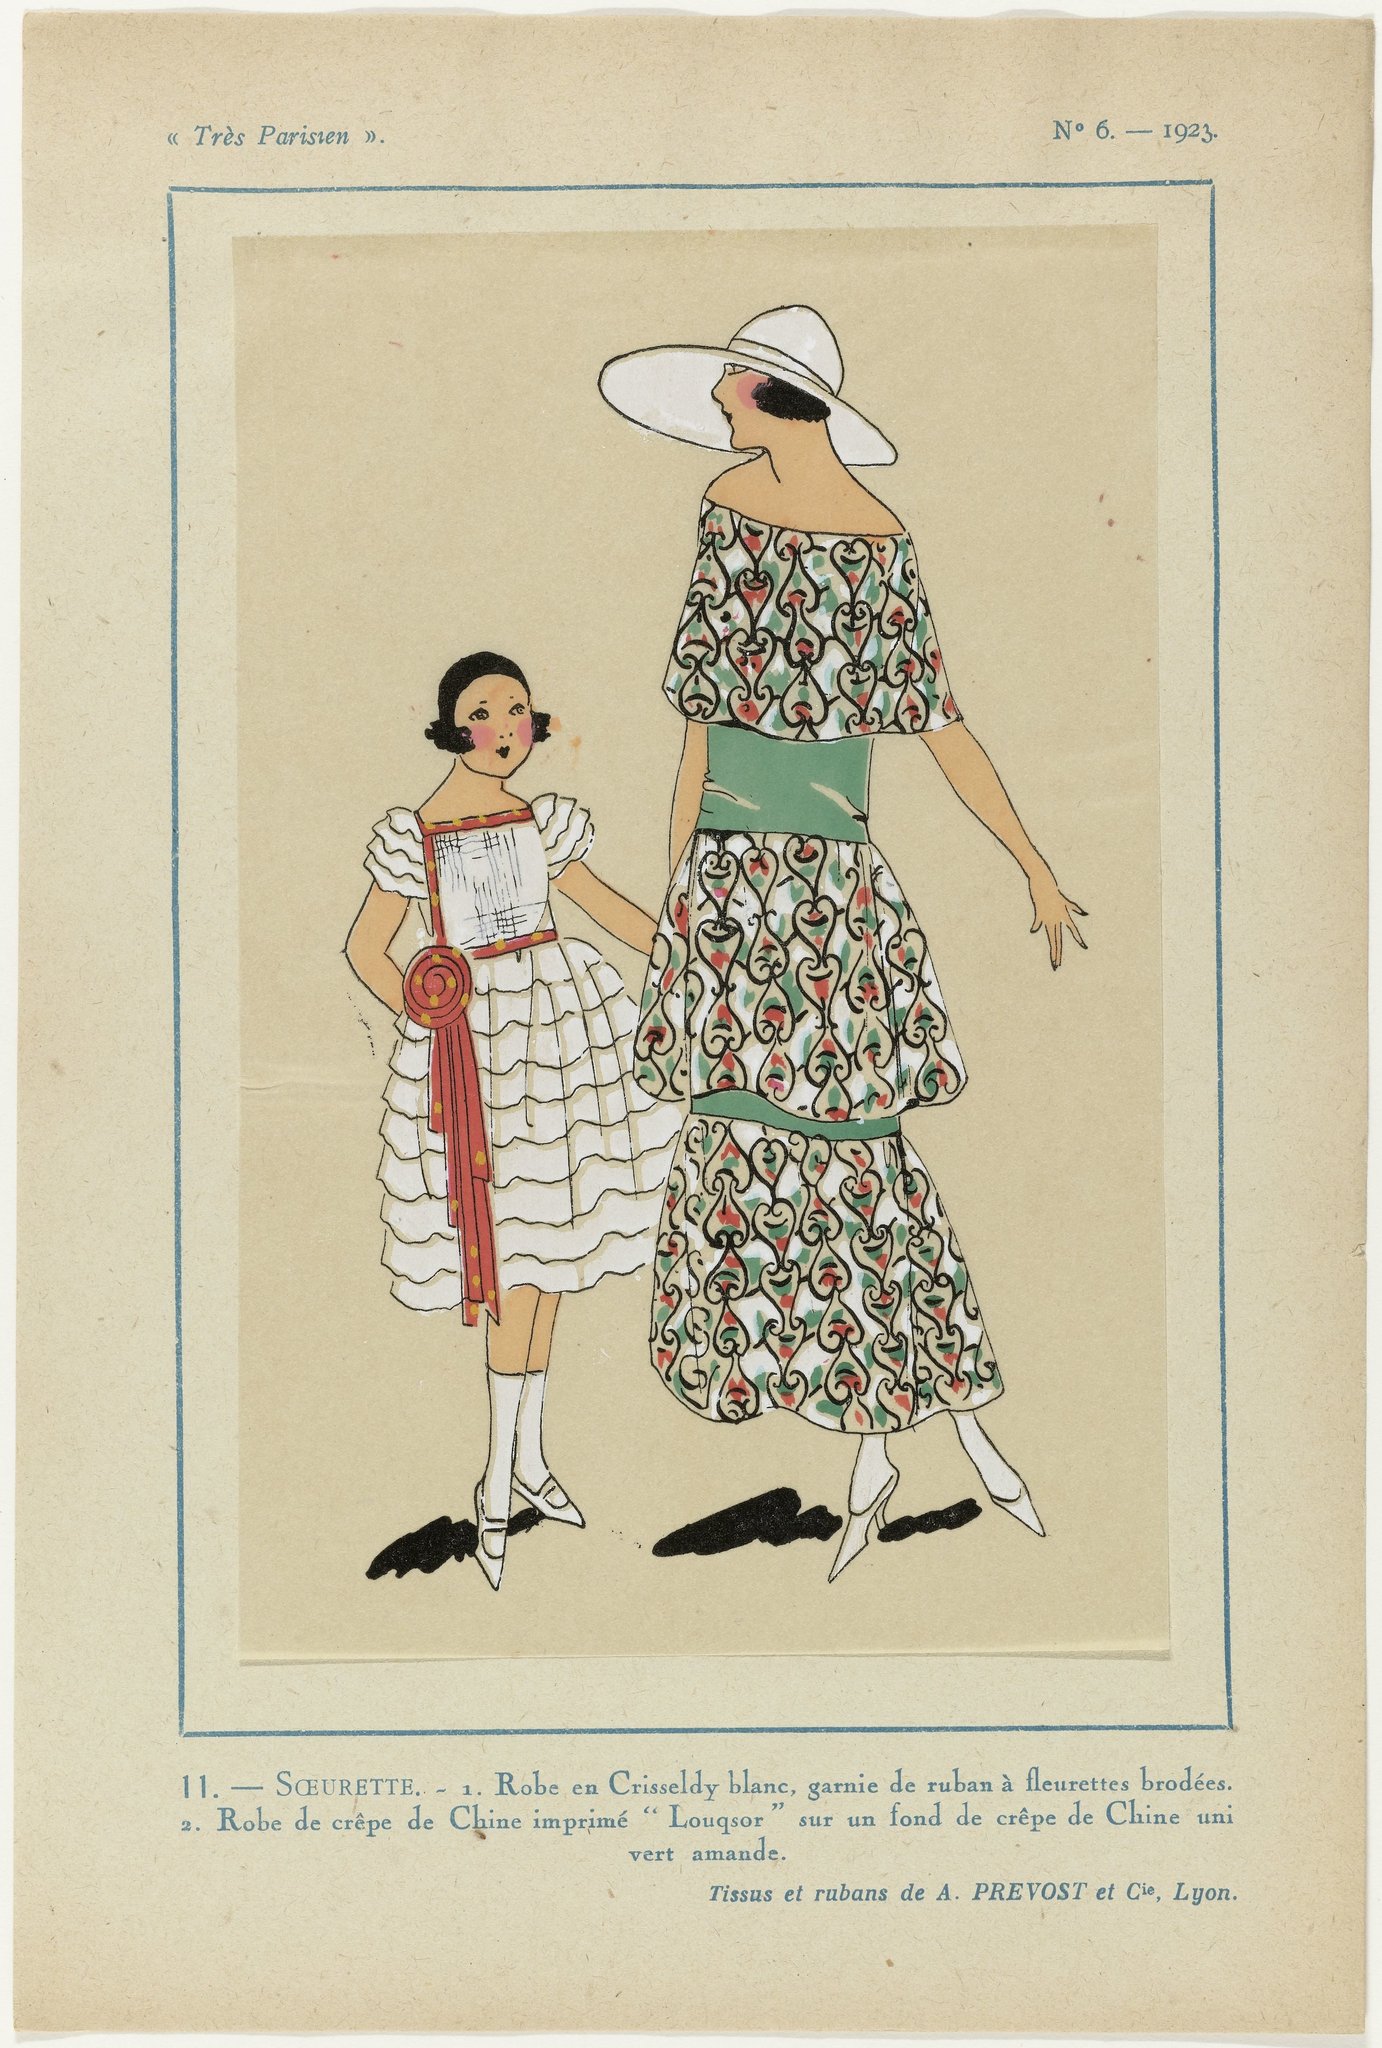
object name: fashion print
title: Très Parisien, 1923, No 6: 11.-SOEURETTE. - 1. Robe en Crisseldy blanc...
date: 1923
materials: paper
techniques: hand coloring, letterpress printing, lithography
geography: paris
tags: embroidery (ornamentation) (+ women's clothes), border, ribbon, braid (+ women's clothes), stockings, socks (+ girls' clothes), fashion plates, head-gear: hat (+ women's clothes), dress, gown (+ women's clothes), sisters (second degree family relationships), dress, gown (+ girls' clothes)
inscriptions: title: ‘Très Parisien / No 6. - 1923’, caption: ‘11. - SOEURETTE. - 1. Robe en Crisseldy blanc, garnie de ruban à fleurettes brodées. 2. Robe de crêpe de Chine imprimé "Louqsor" sur un fond de crêpe de Chine uni vert amande. / Tissus et rubans de A. PREVOST et Cie, Lyon.’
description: 1. Kinderjurk van witte Crisseldy, gegarneerd met lint met geborduurde bloemen. 2. Jurk van bedrukte crêpe de Chine "Louqsor" op een ondergrond van effen amandelgroene crêpe de Chine. Stoffen en linten van A. Prevost et Cie. Accessoires: hoed met brede rand, pumps. Prent uit het modetijdschrift Très Parisien (1920-1936).